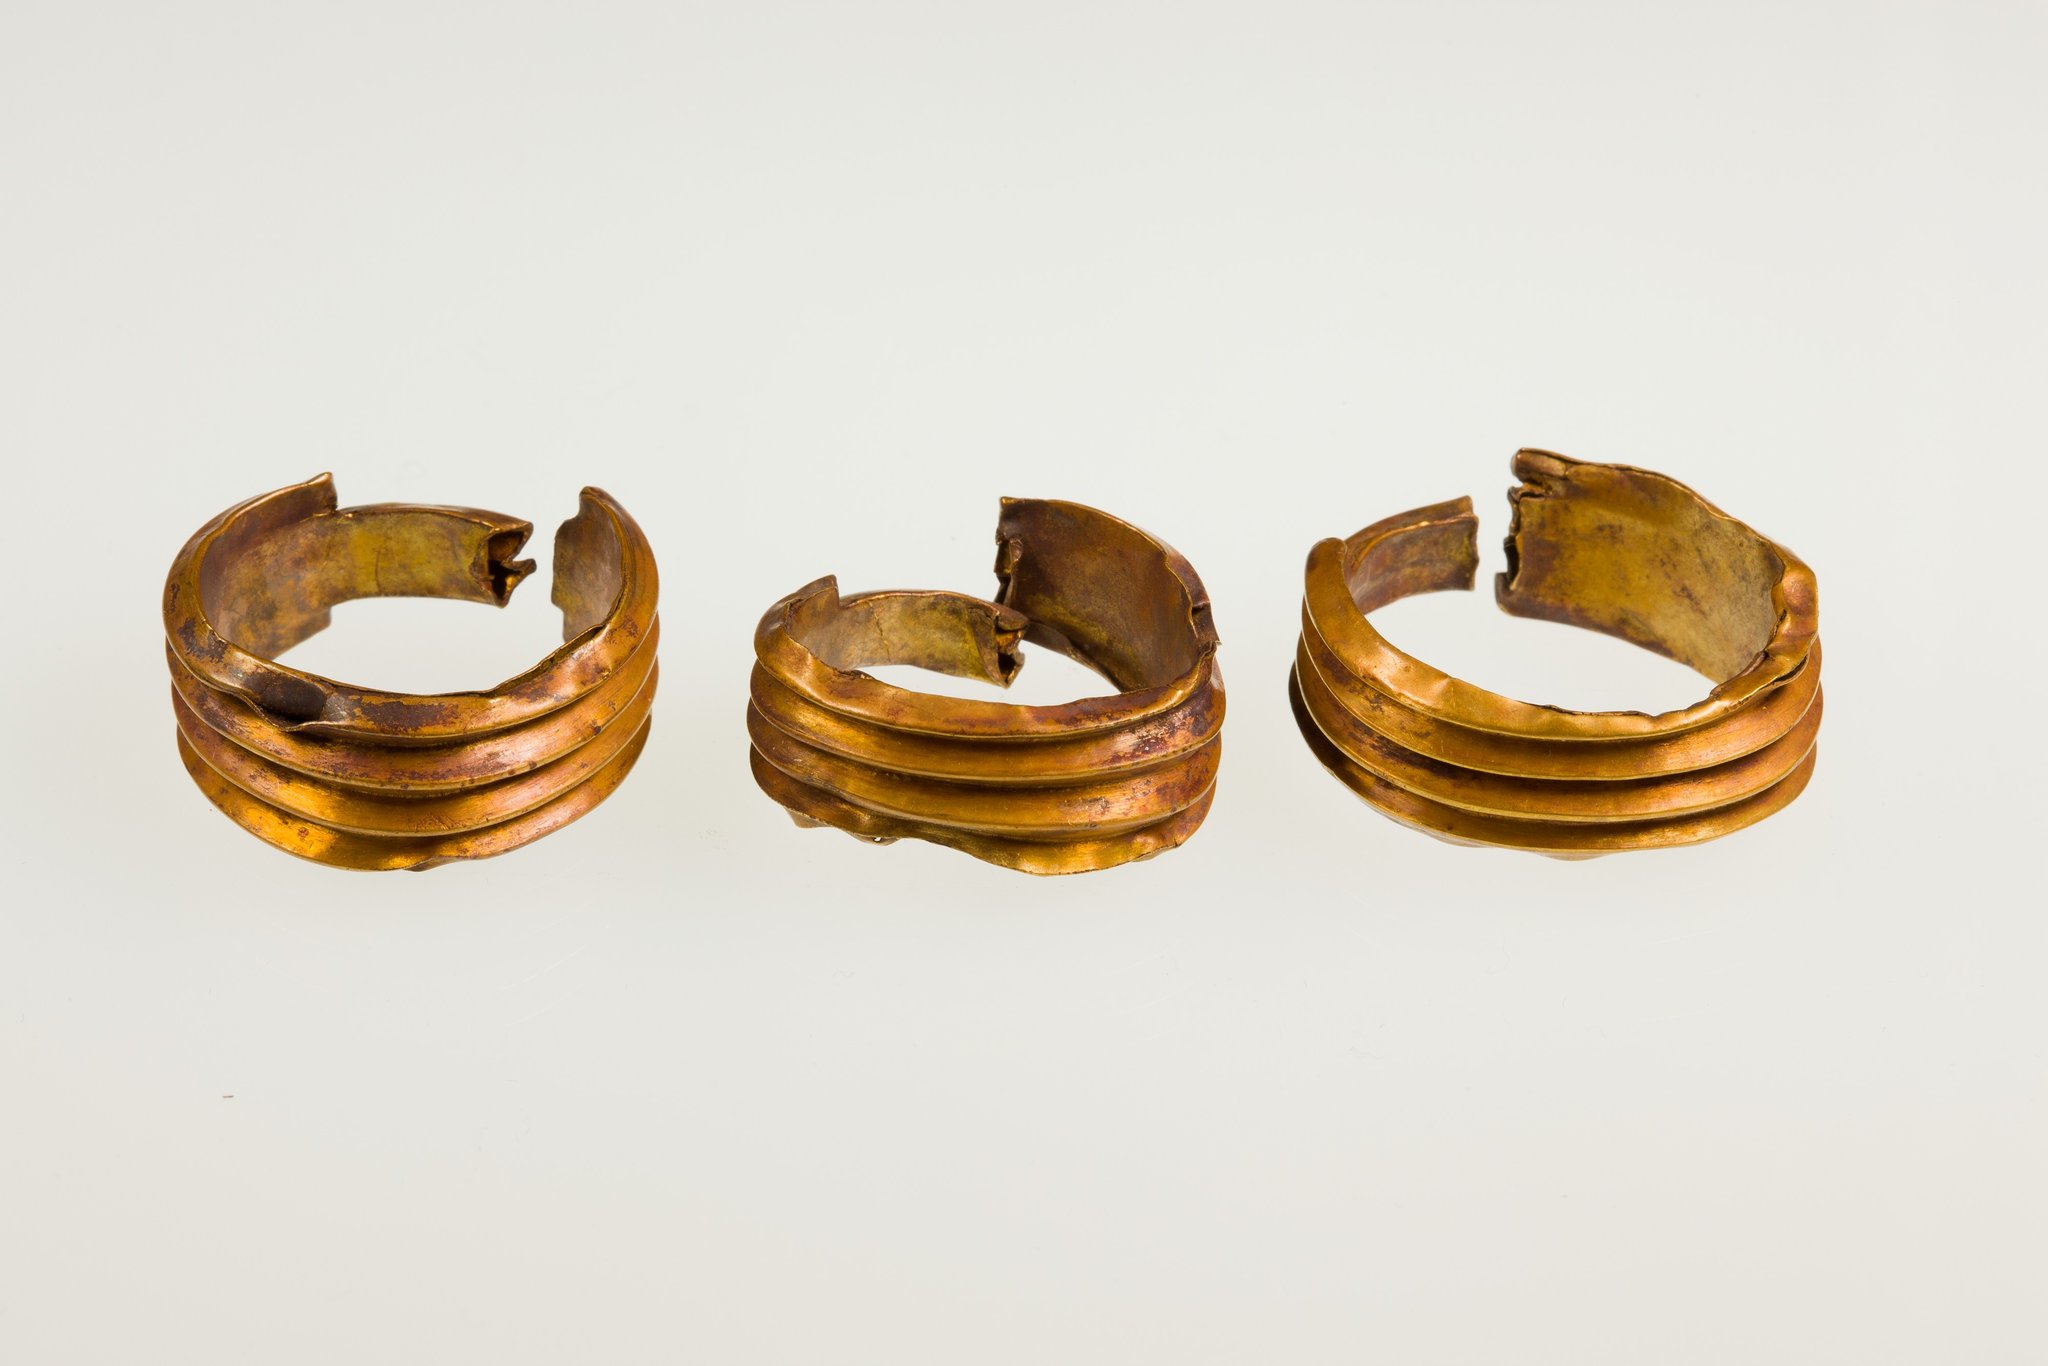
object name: earring, penannular, ribbed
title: Ribbed Penannular Earring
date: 1550-1425 BCE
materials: gold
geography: egypt